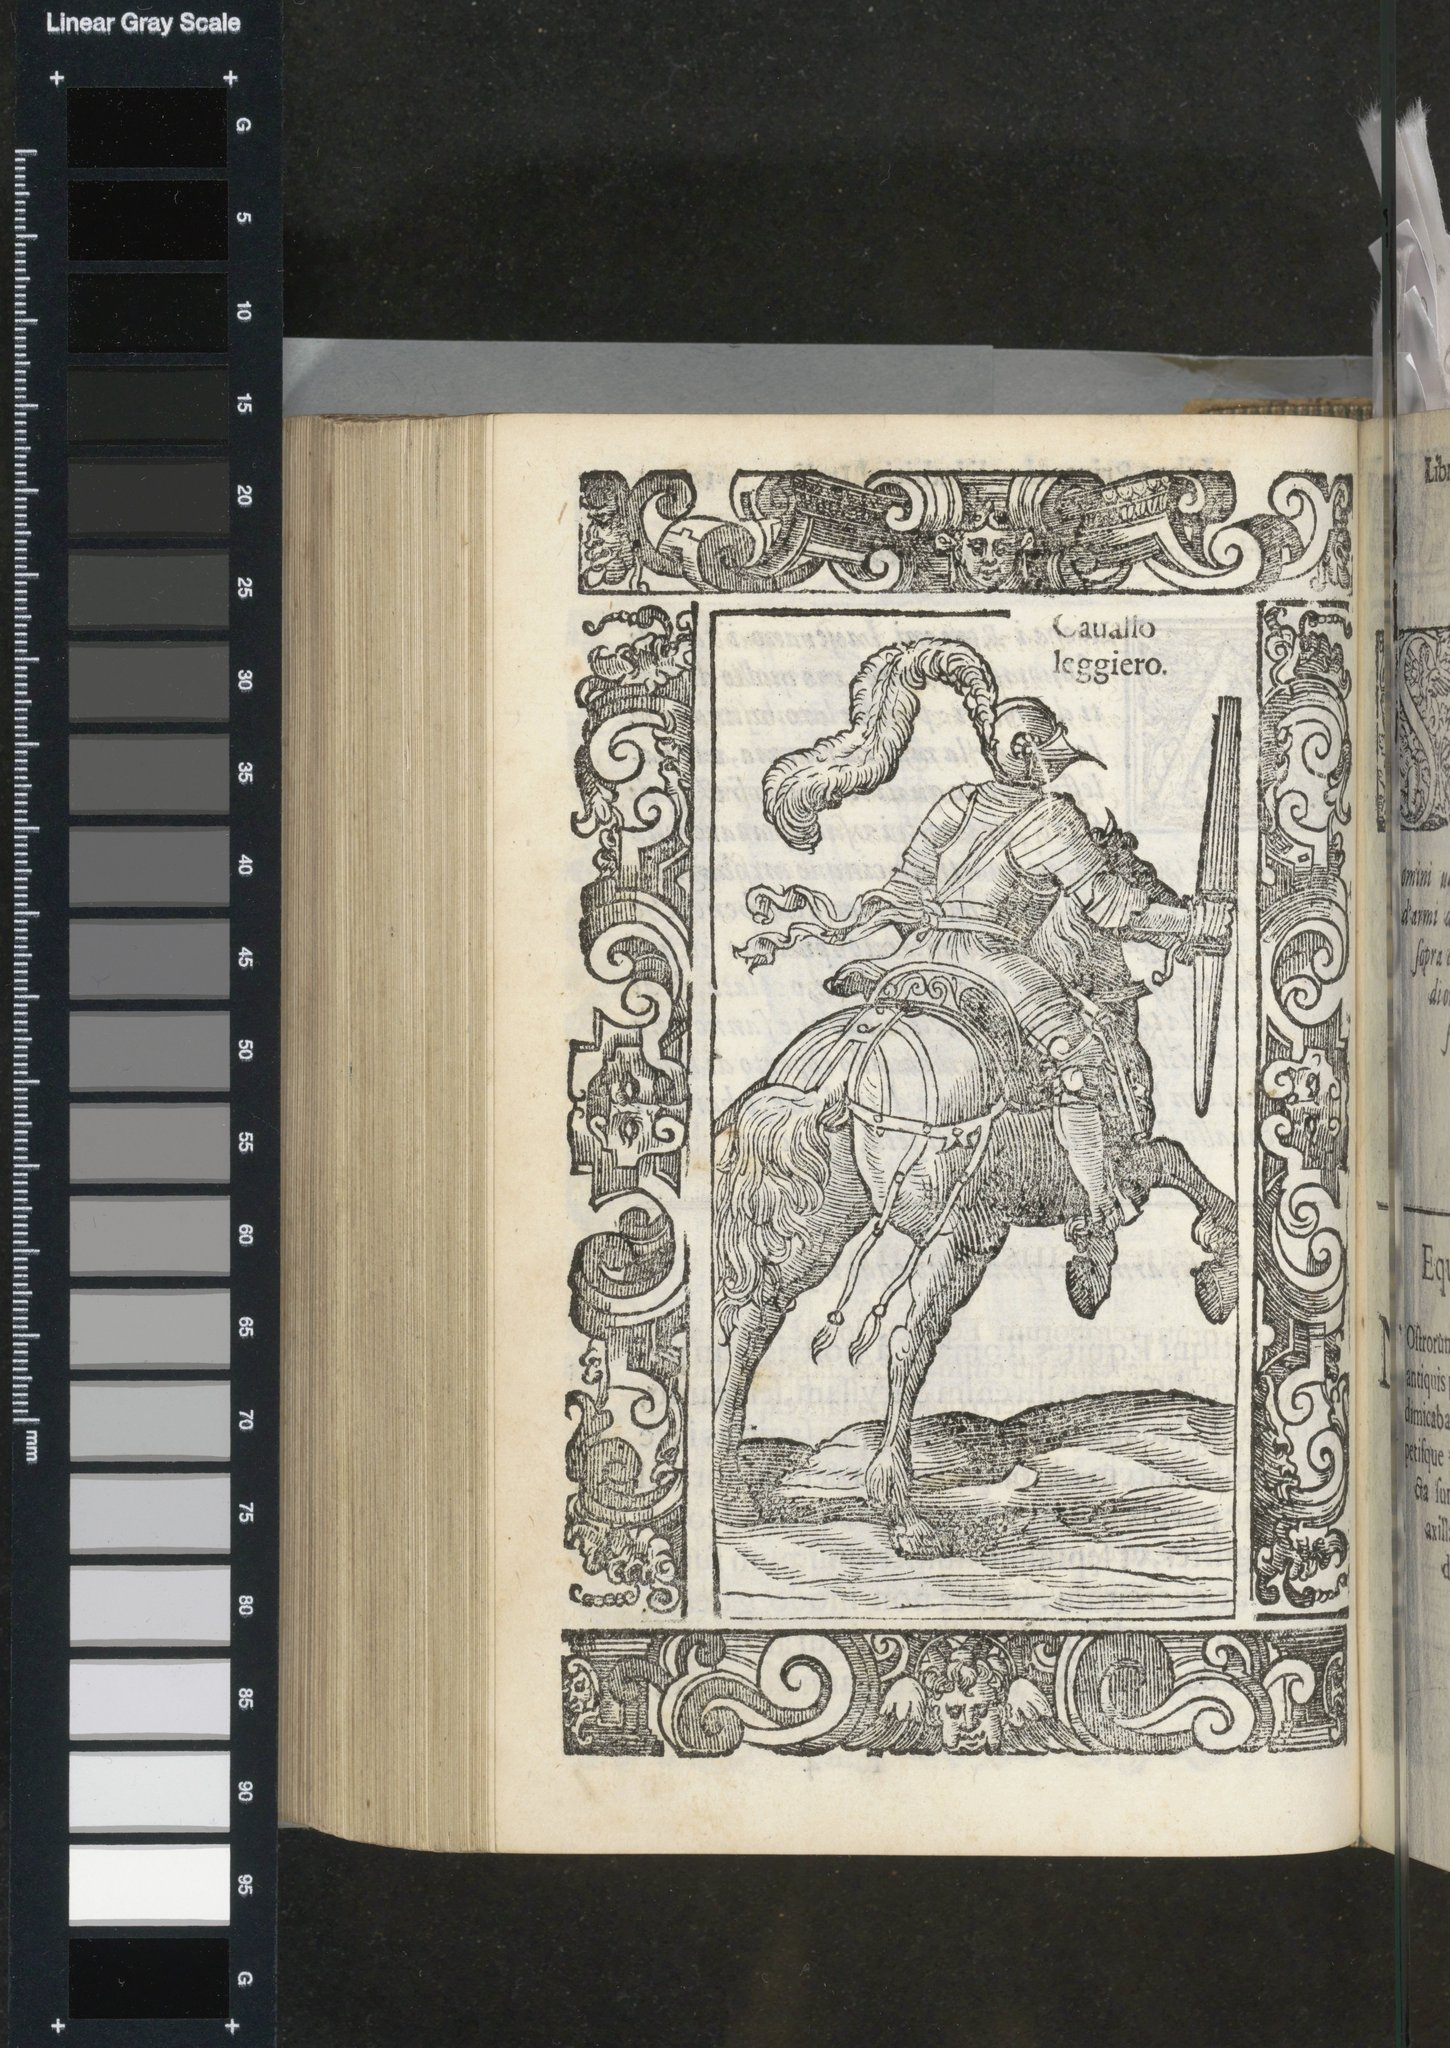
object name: costume print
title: Cavallo leggiero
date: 1598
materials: paper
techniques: woodcut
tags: fashion plates